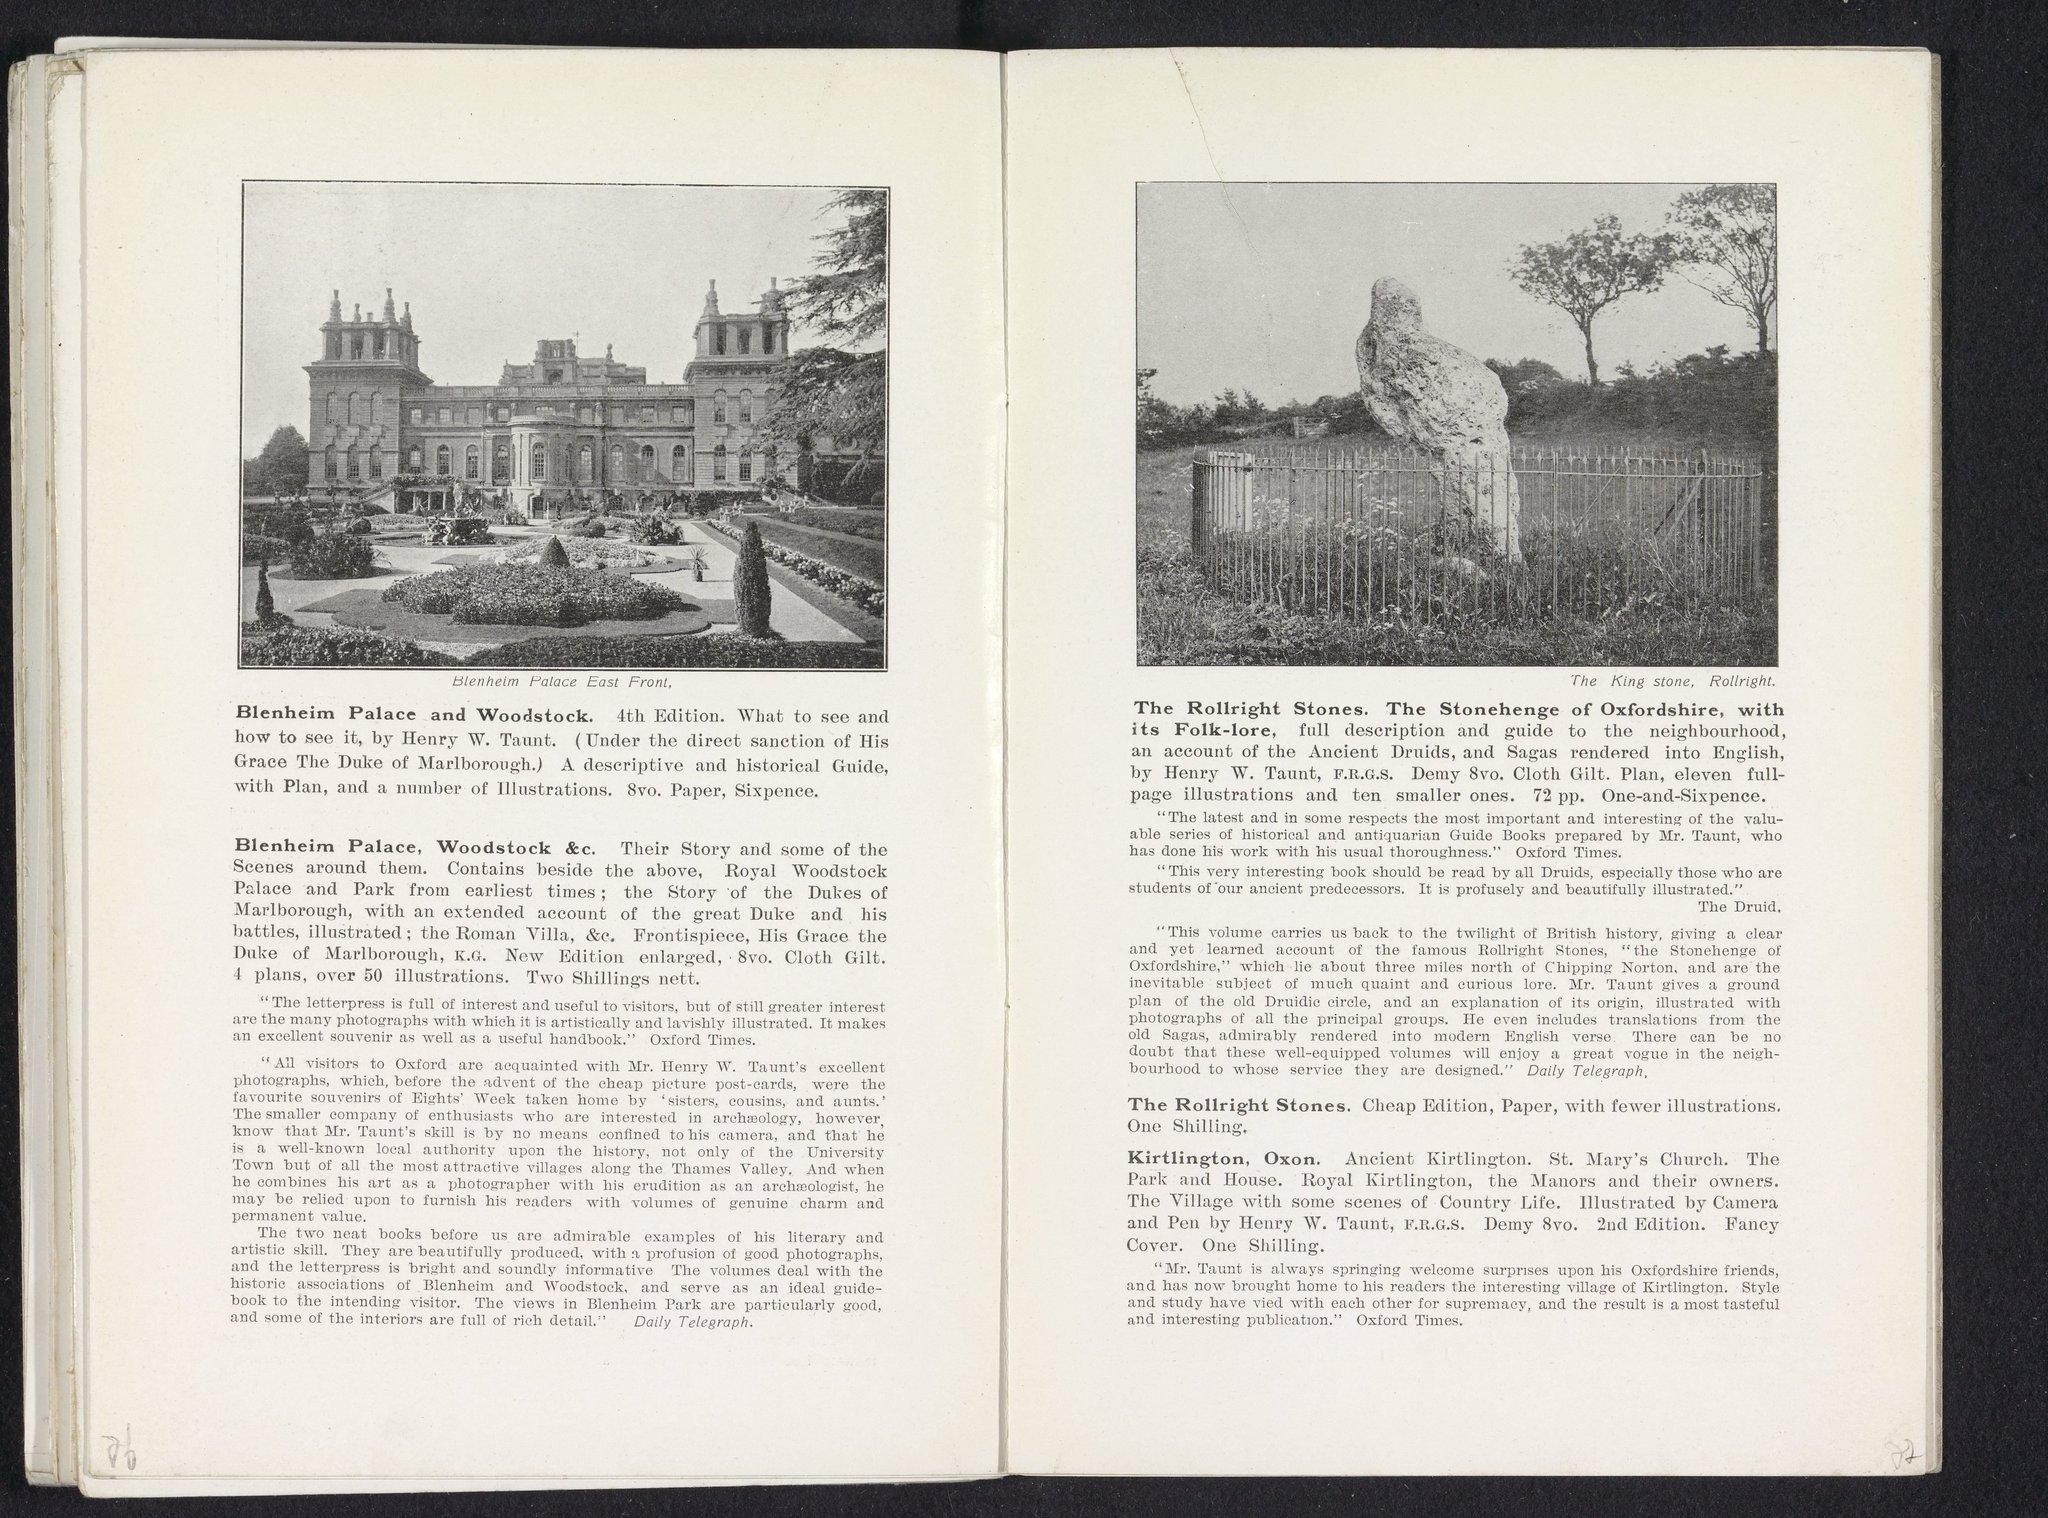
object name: photomechanical print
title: The King Stone, Rollright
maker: henry w. taunt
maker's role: fotograaf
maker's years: 1842-1922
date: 1907-1912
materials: paper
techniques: autotype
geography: oxfordshire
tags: boulder, stone